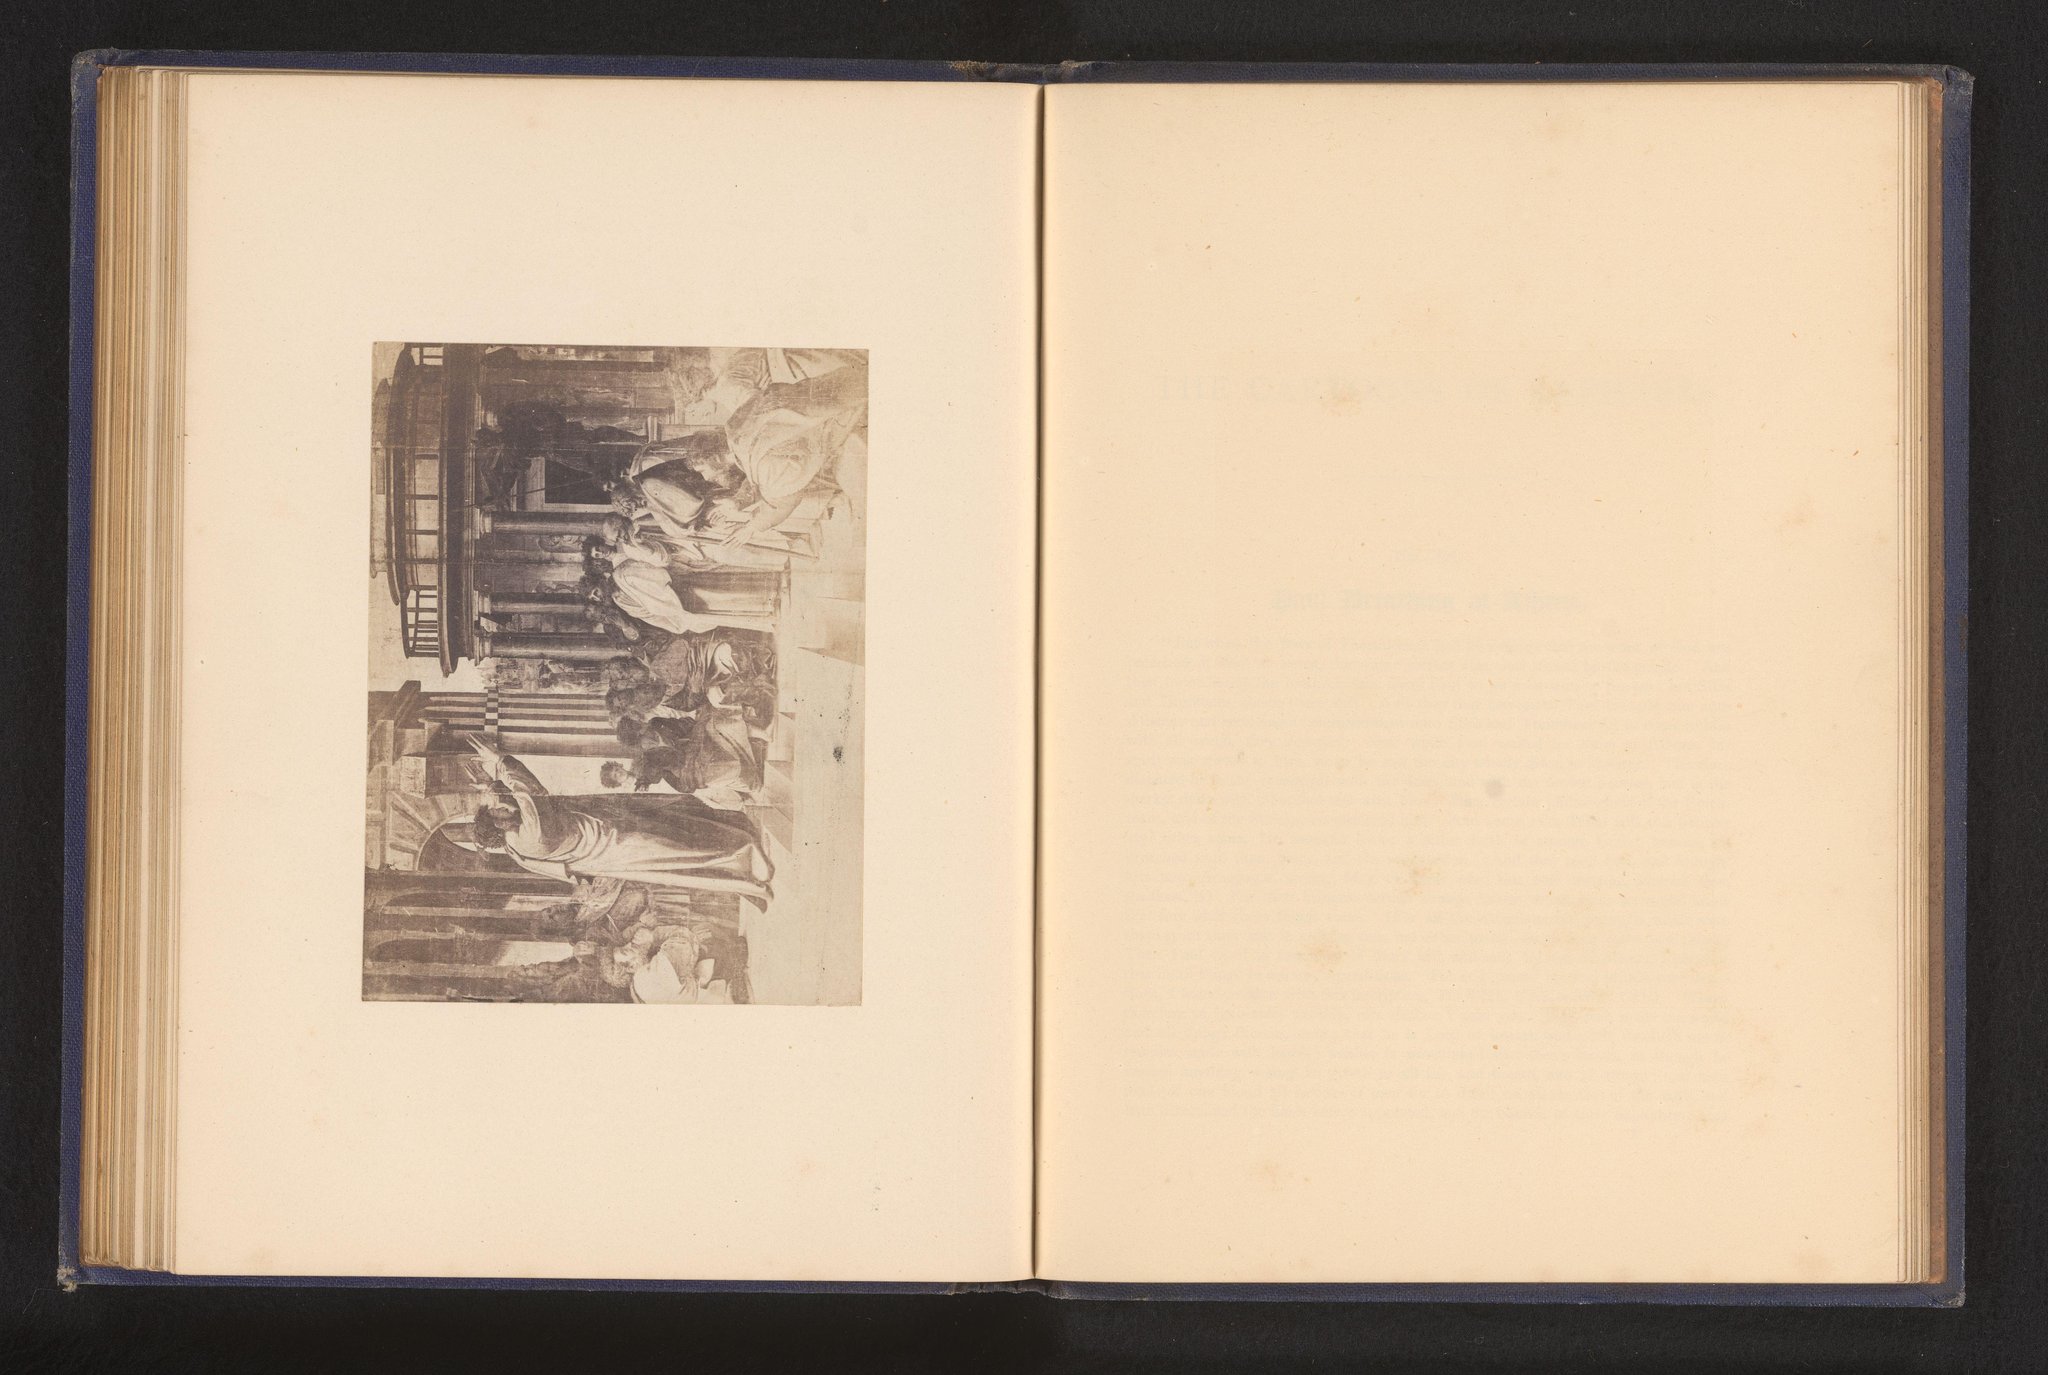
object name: photograph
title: Fotoreproductie van Paul preaching at Athens door Rafaël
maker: Anonymous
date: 1863-1868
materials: paper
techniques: albumen print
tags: drawing, sketch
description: Foto op tweede ongenummerde pagina na pagina 82.